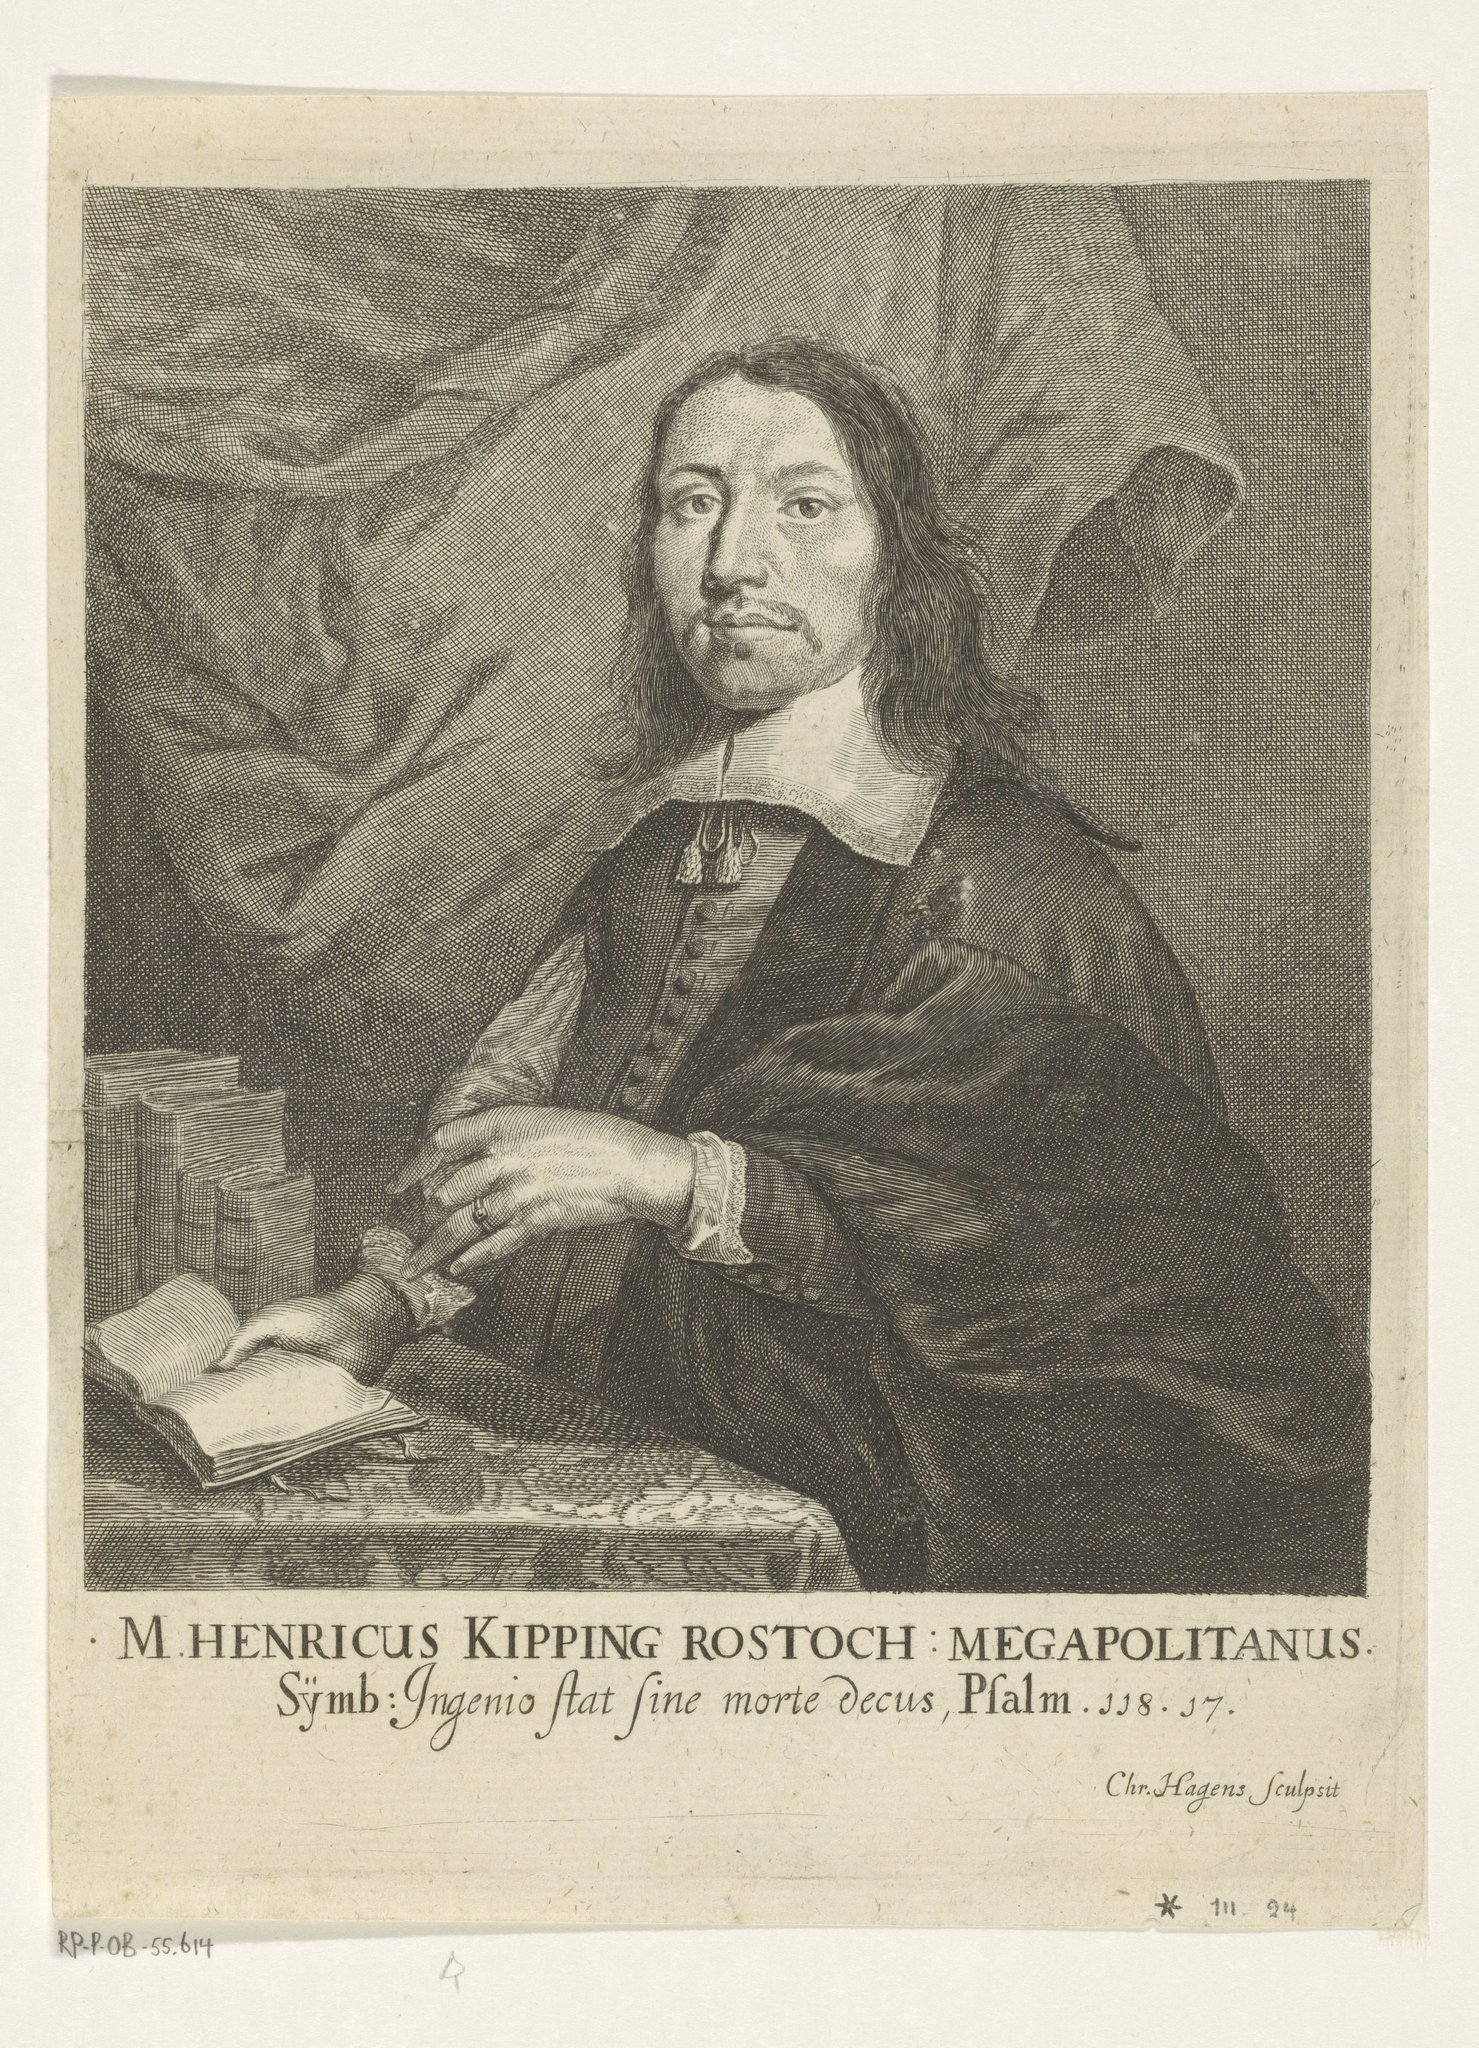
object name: print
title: Portret van Henricus Kipping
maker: christiaan hagen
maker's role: draughtsman, print maker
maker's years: 1635-1707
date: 1663-1695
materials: paper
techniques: engraving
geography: amsterdam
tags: moustache, book - mm - book open, table, book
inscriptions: collector's mark: Lugt 2228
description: Portret ten halven lijve naar links van Henricus Kipping bij een tafel met boeken. Onder zijn portret twee regels in Latijn.